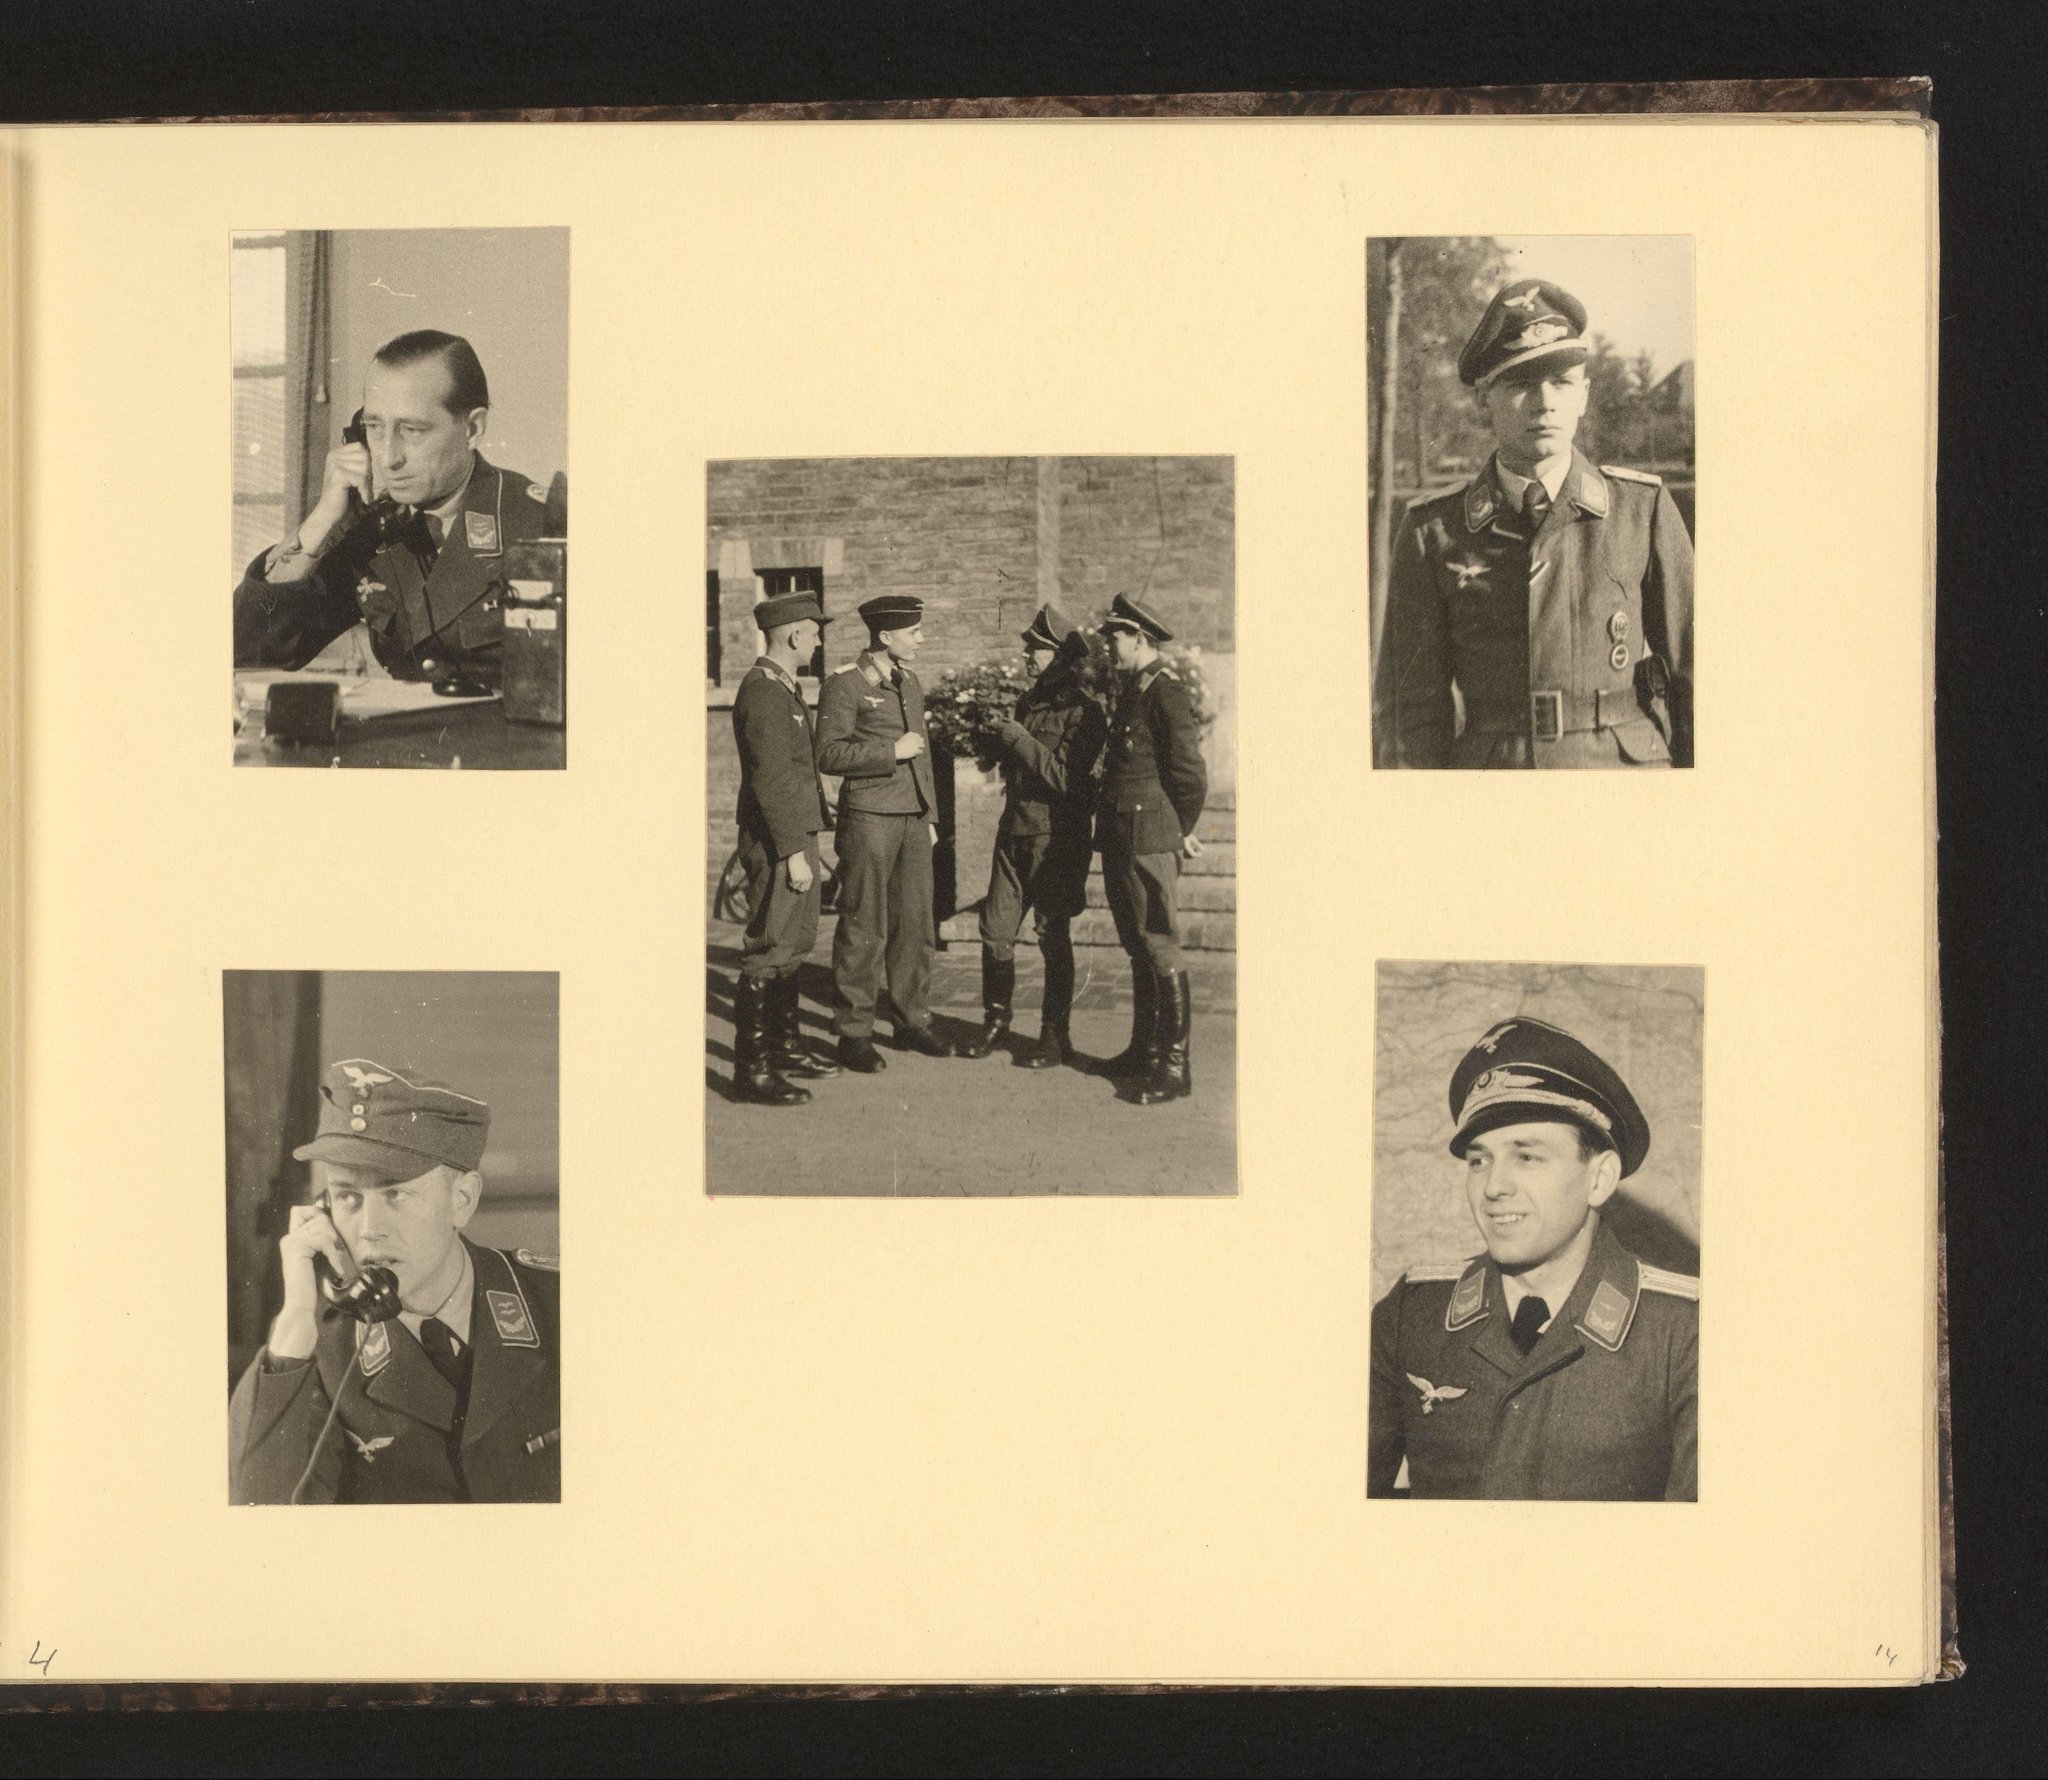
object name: photograph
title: Officieren van de compagnie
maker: Anonymous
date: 1942-1943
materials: cardboard, photographic support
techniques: gelatin silver print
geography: breda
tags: barracks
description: Albumblad met vijf foto's van de officieren van de compagnie. Onderdeel van het fotoalbum van de Luftnachrichten-Regiment 211,1942-1943.